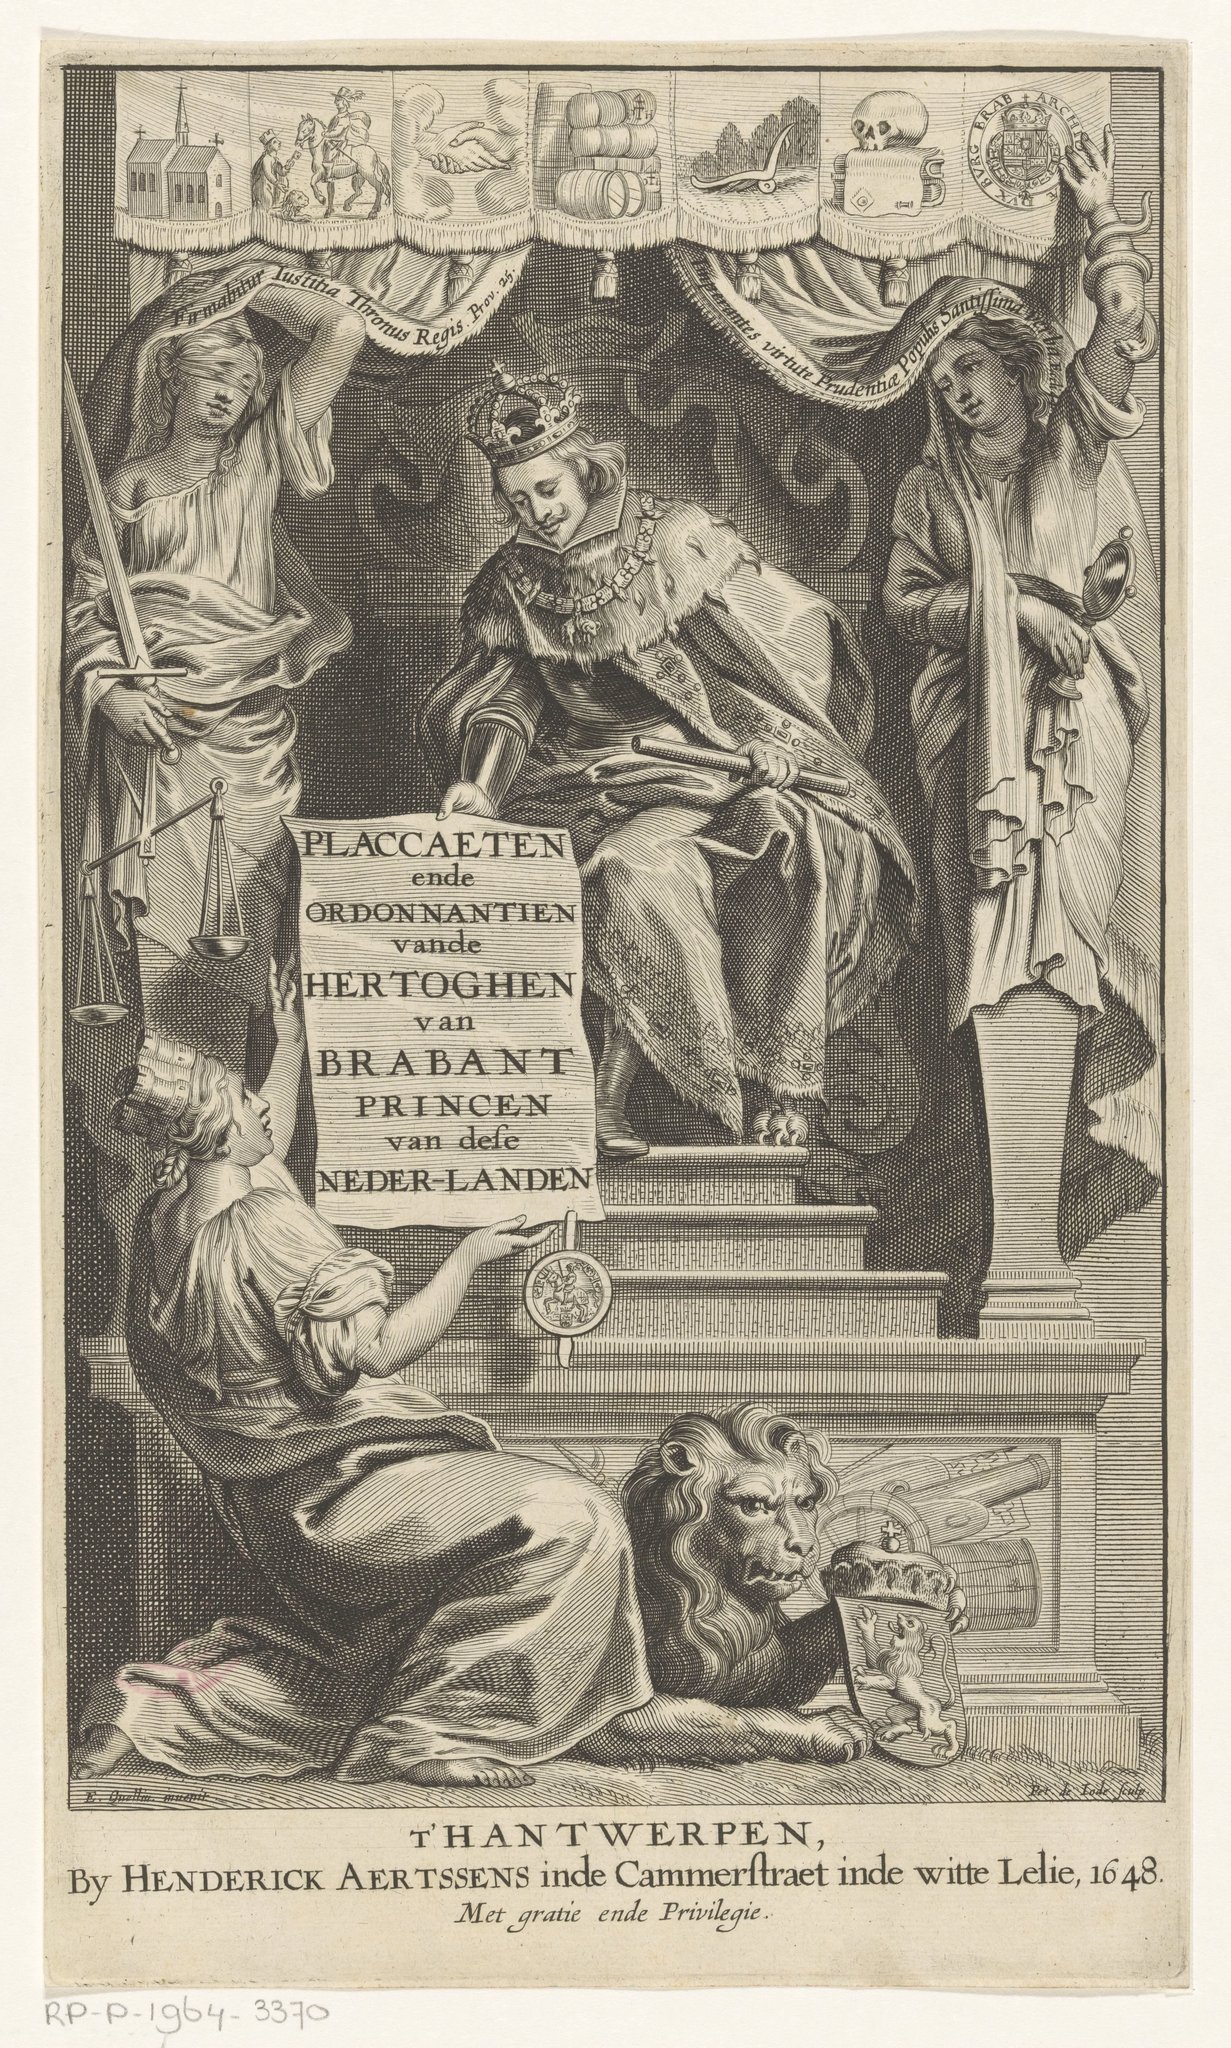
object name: titelblad, titelpagina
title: Placcaeten ende ordonnantien vande hertoghen van Brabant princen van deze Neder-landen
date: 1648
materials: paper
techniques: engraving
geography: antwerp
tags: personification of a city, town-patron(ess), ruler, sovereign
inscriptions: collector's mark: Lugt 2760, collector's mark: ‘Bibliotheqe royale de Belgique / Double échangé on vendu’, collector's mark: Lugt 2228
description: Een hertog op een troon. Op het baldakijn boven de troon staan diverse symbolen. De hertog wordt geflankeerd door een standbeeld van Gerechtigheid (Justitia) en van Voorzichtigheid (Prudentia). Met zijn rechterhand overhandigt hij een papier aan een vrouwelijke personificatie van een stad. Zij is gekroond met een muurkroon. Een leeuw met het wapenschild van de hertogen van Brabant ligt aan haar voeten.